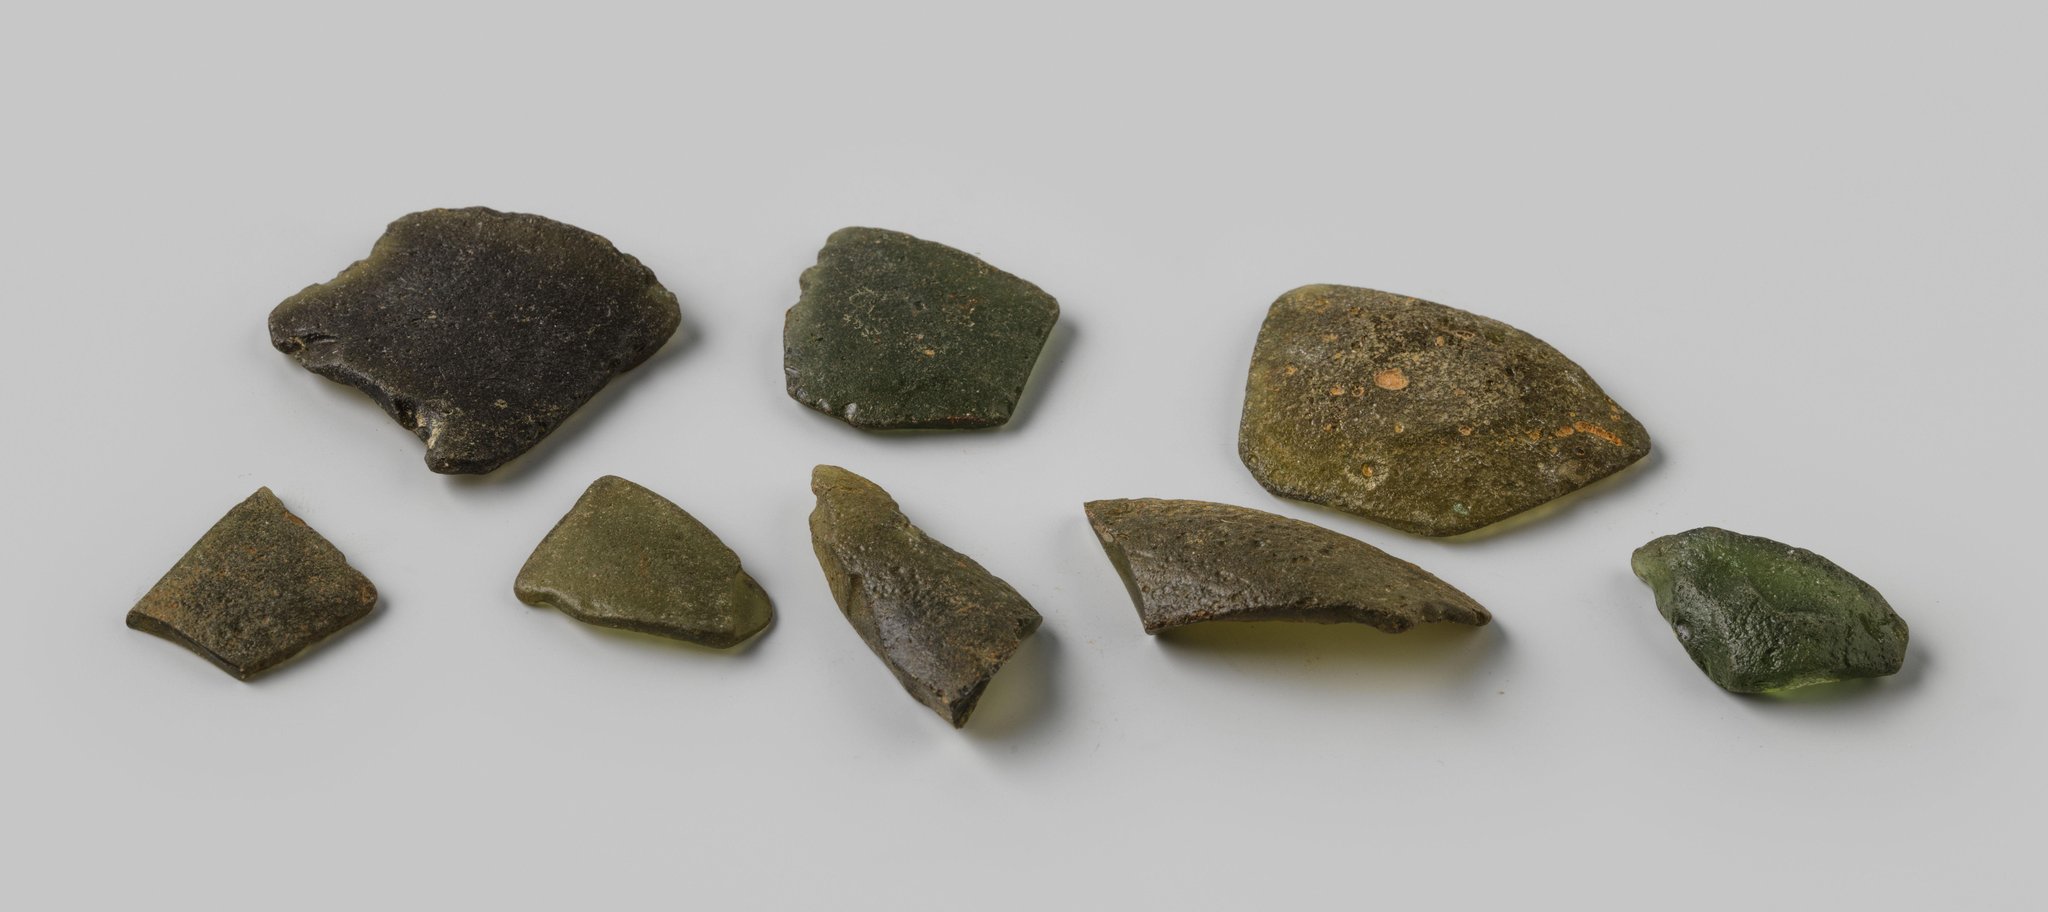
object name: wine bottle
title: Scherven van wijnflessen uit het wrak van de Oost-Indiëvaarder Hollandia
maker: Anonymous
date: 1700-1743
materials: glass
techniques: green glass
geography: netherlands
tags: verenigde oostindische compagnie, hollandia (schip)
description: Typologically not identifiable, belly, fragment.